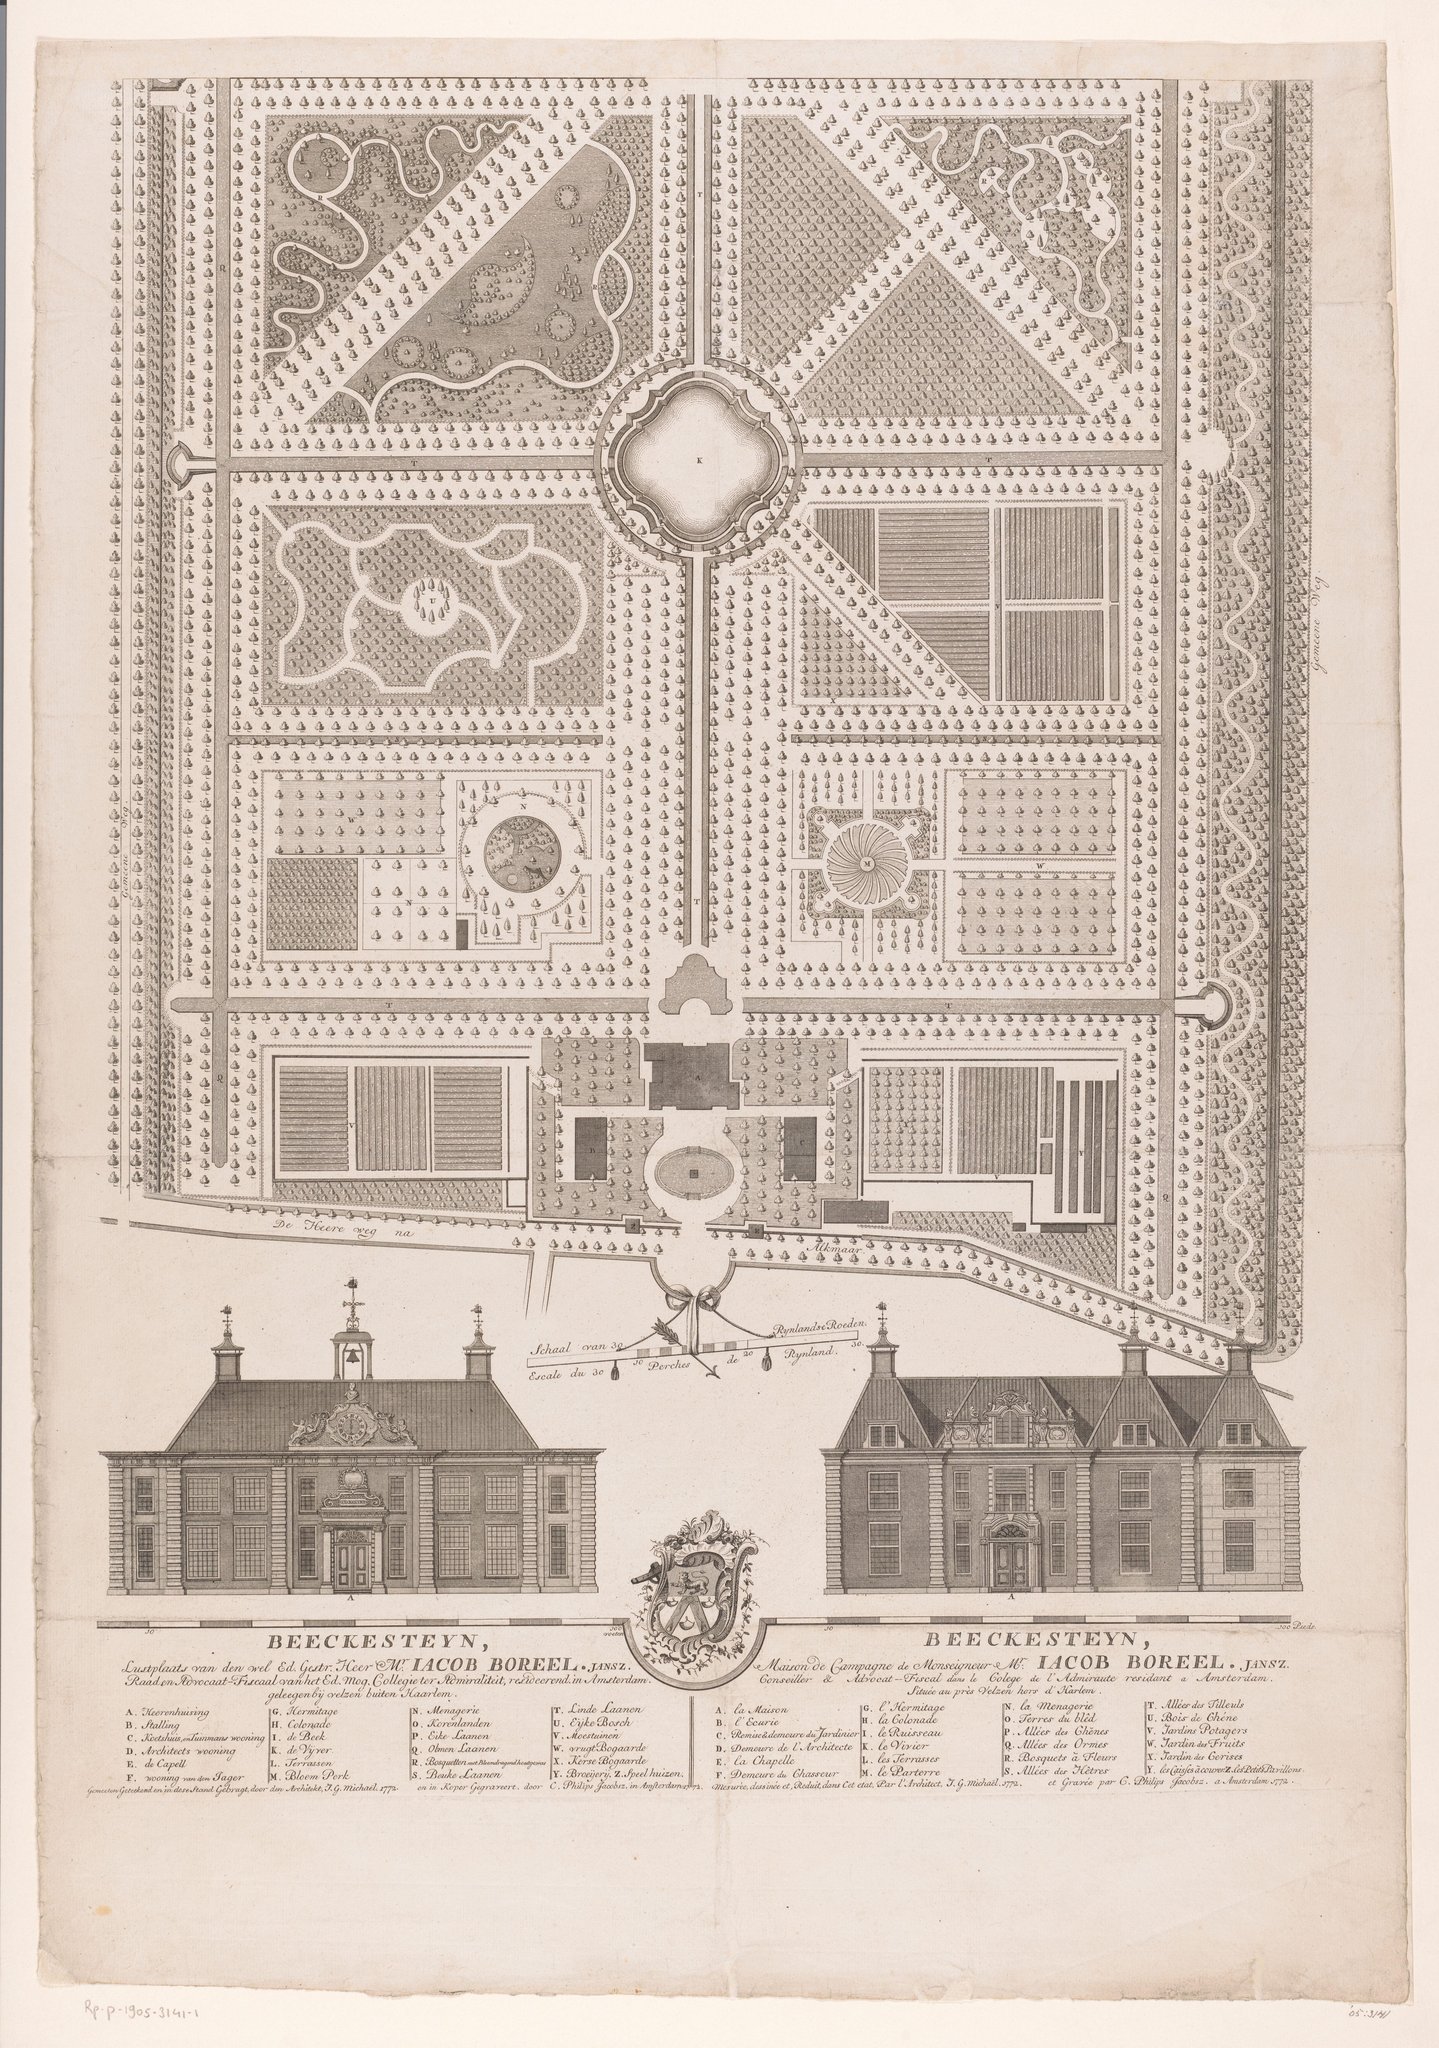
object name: area plan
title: Beeckesteyn, lustplaats van den wel Ed. Gestr. Heer Mr. Jacob Boreel (...) / Beeckesteyn, maison de campagne de monseigneur Mr. Jacob Boreel (...)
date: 1772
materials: paper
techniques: engraving, etching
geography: amsterdam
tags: french or architectonic garden; formal garden, armorial bearing, heraldry, country-house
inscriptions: collector's mark: Lugt 2228